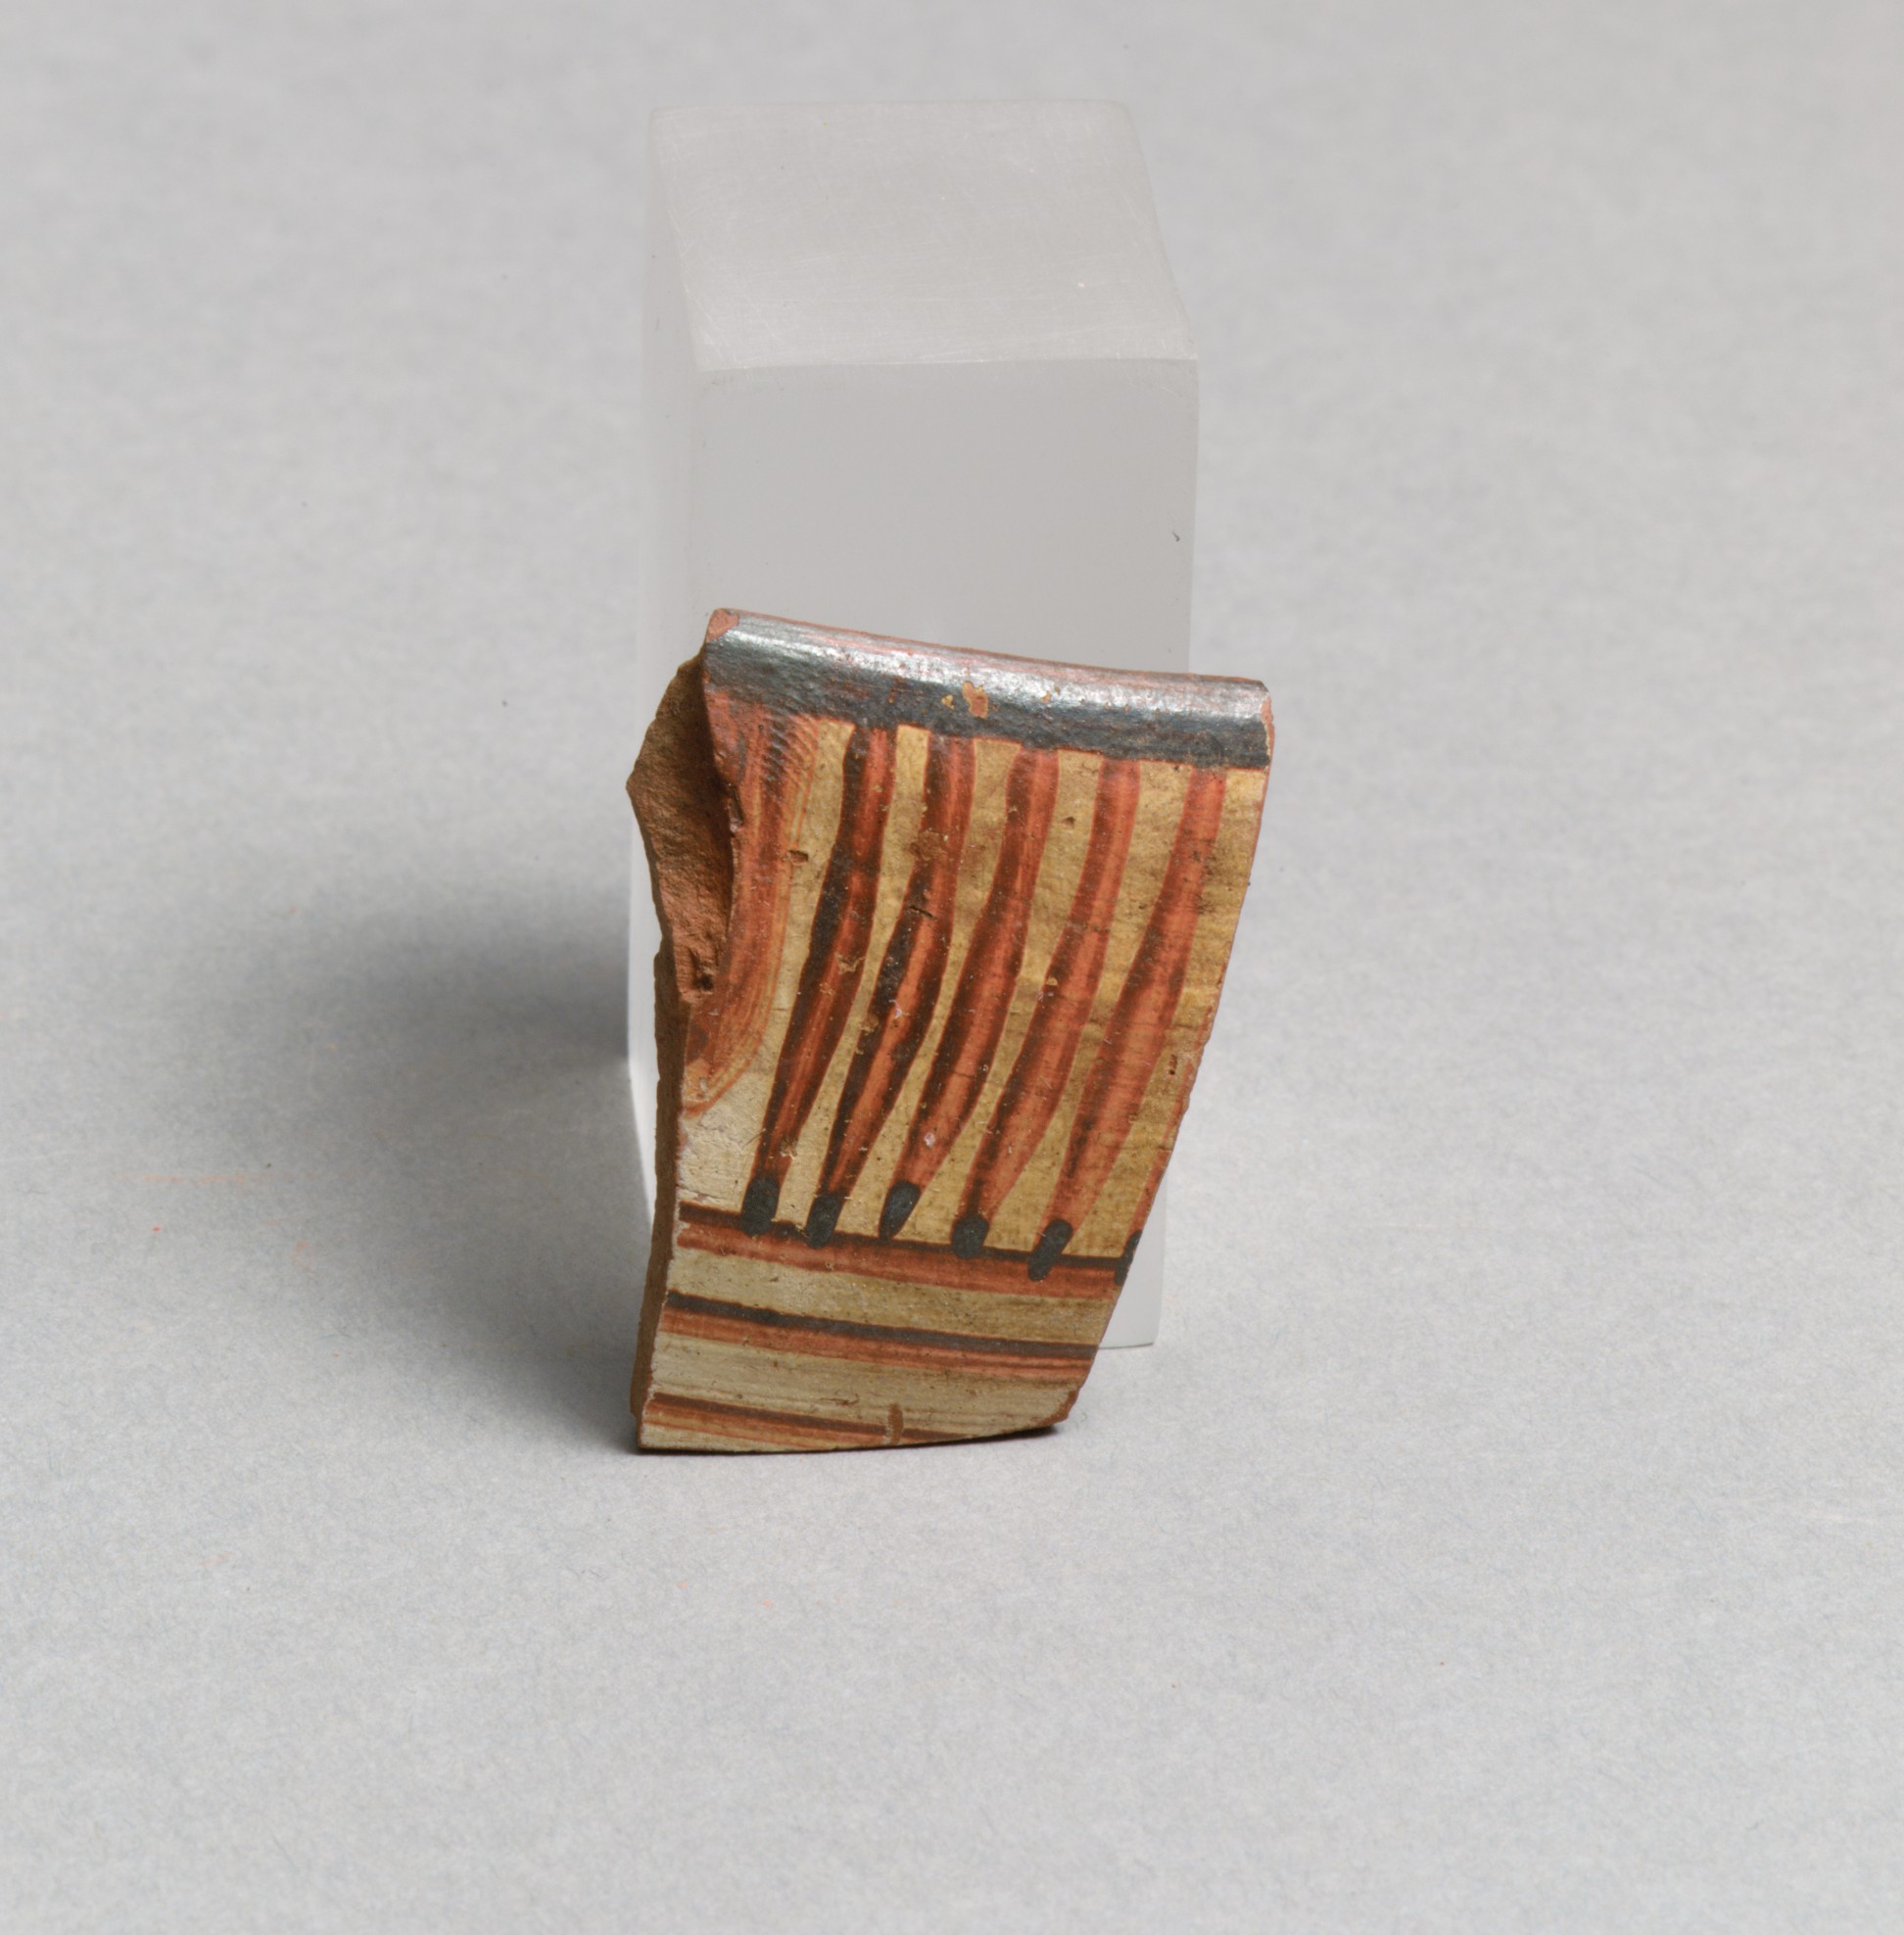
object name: skyphos fragment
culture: greek or lydian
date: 900-30 BCE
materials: terracotta